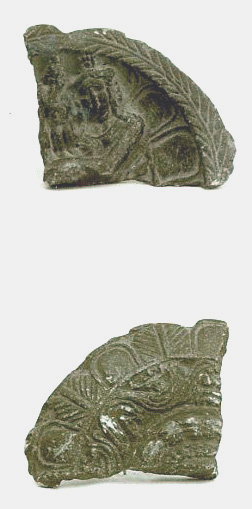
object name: fragment of a bowl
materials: stone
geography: egypt